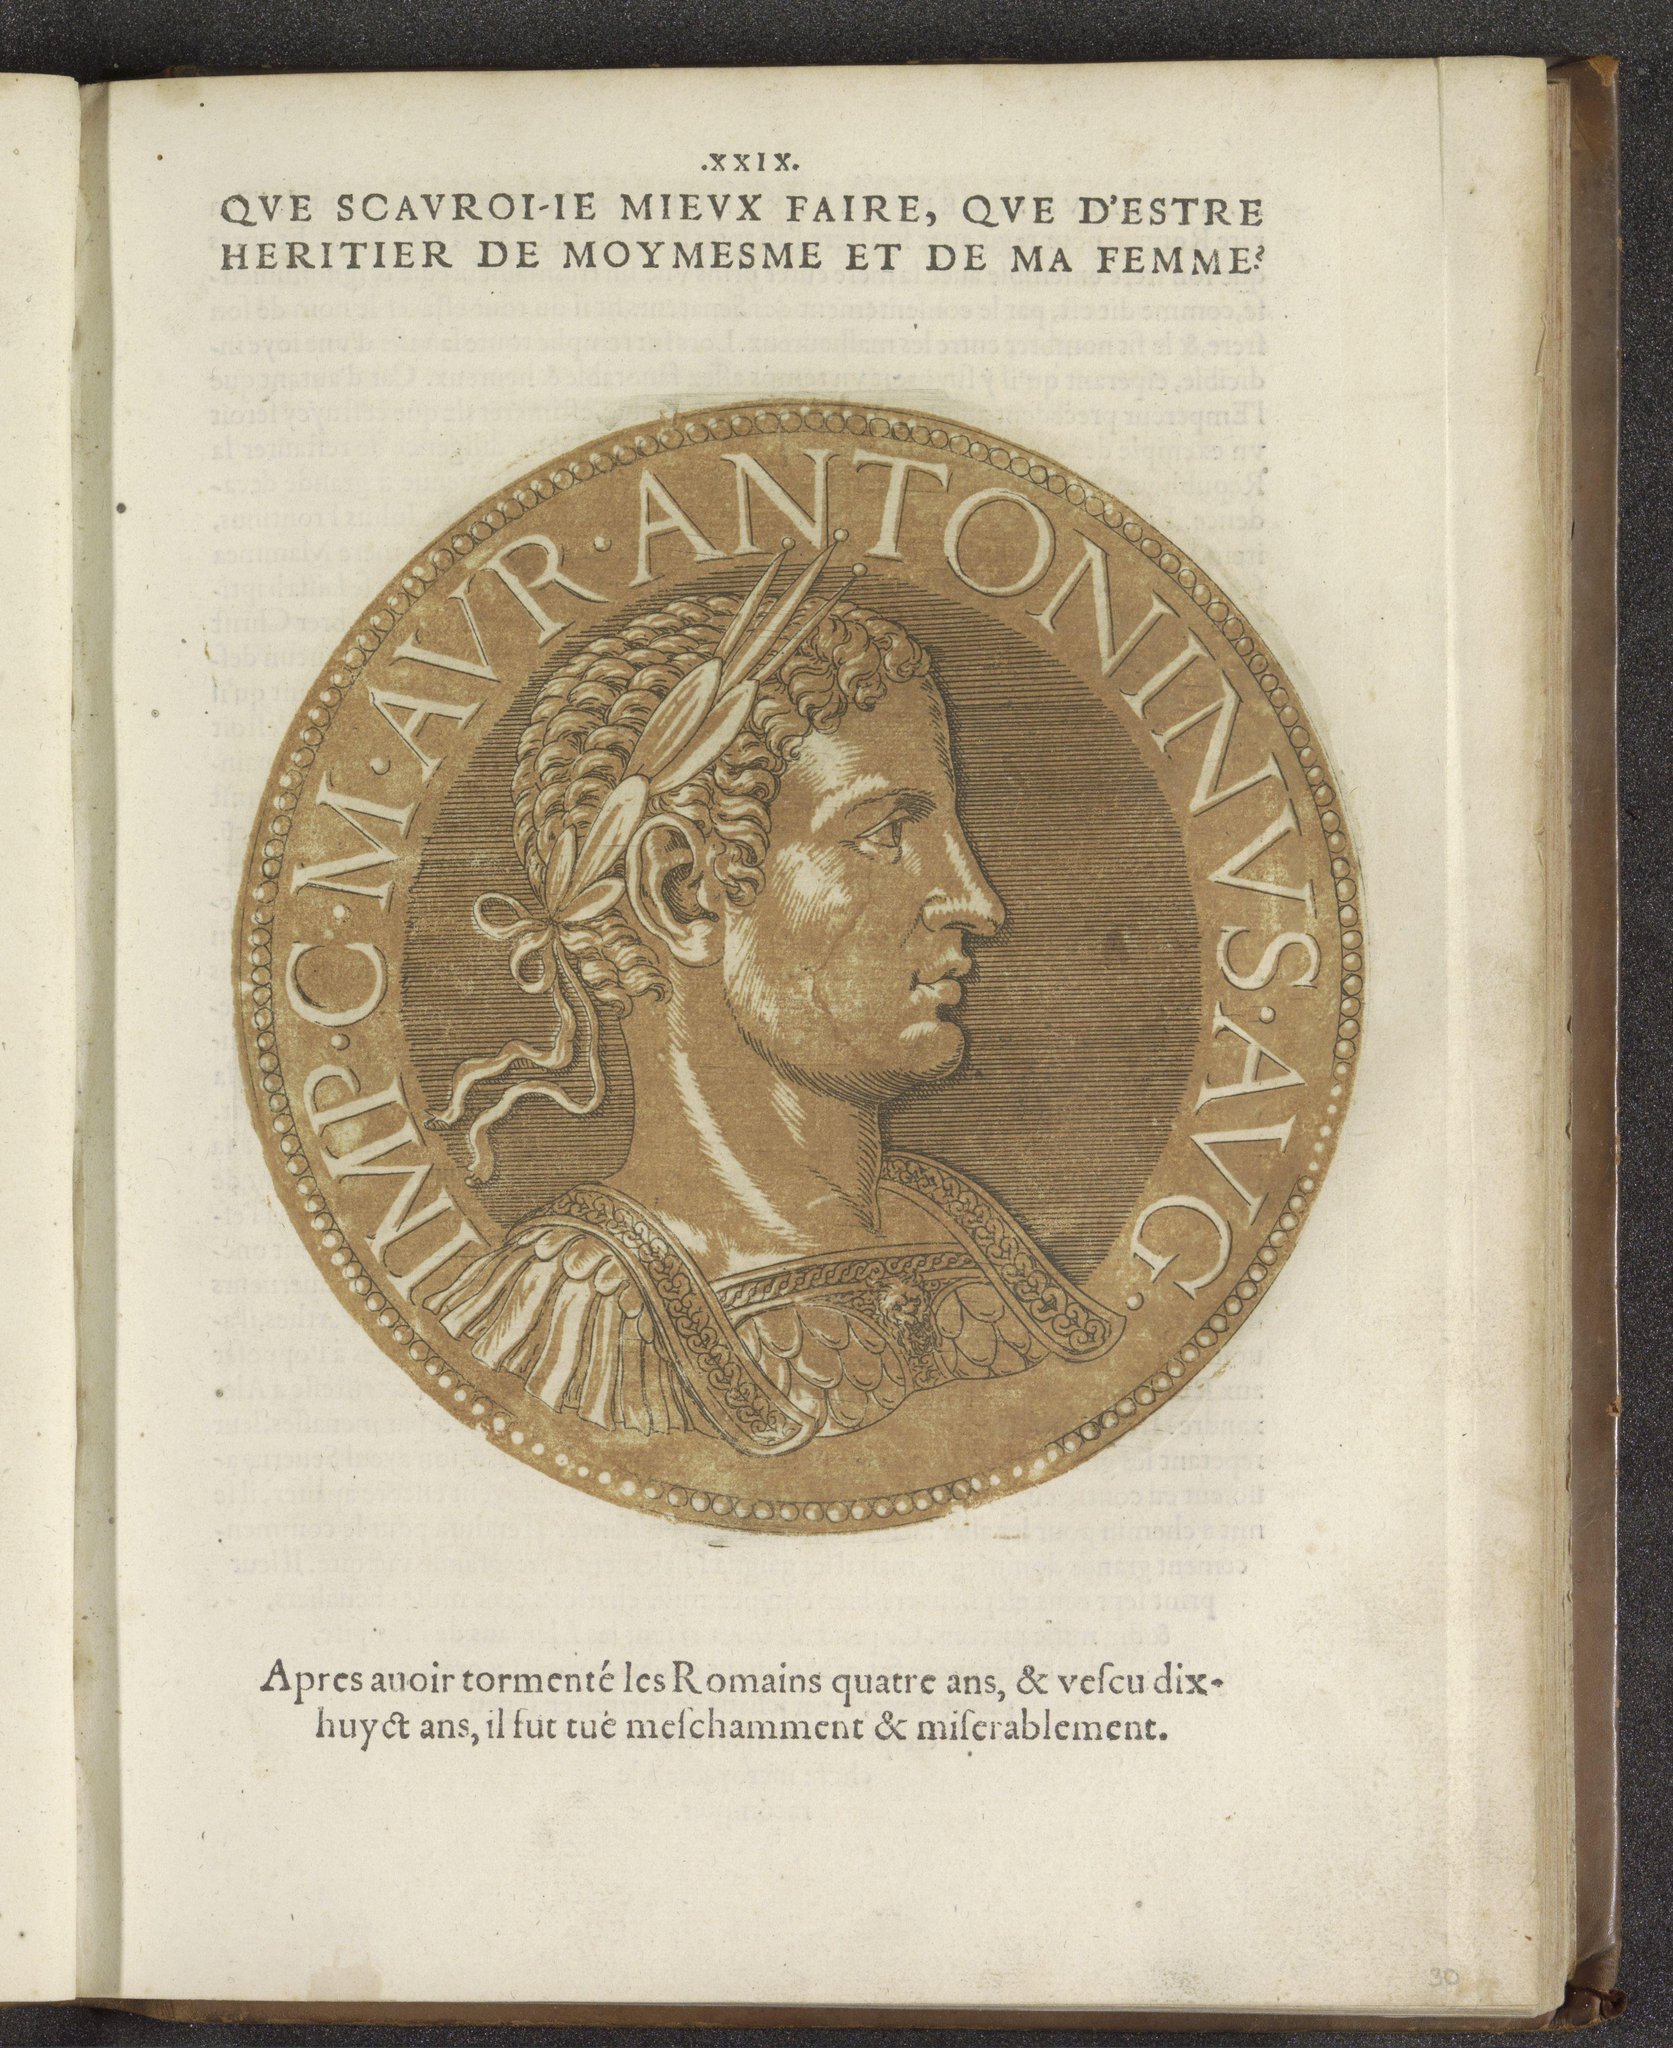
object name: page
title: Portret van keizer Elagabalus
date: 1557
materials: paper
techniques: woodcut, etching, letterpress printing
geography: antwerp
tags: emperor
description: Portret van keizer Elagabalus, op een munt met randschrift. De prent maakt deel uit van een boek over de keizers vanaf Julius Caesar tot en met Karel V en zijn broer Ferdinand.